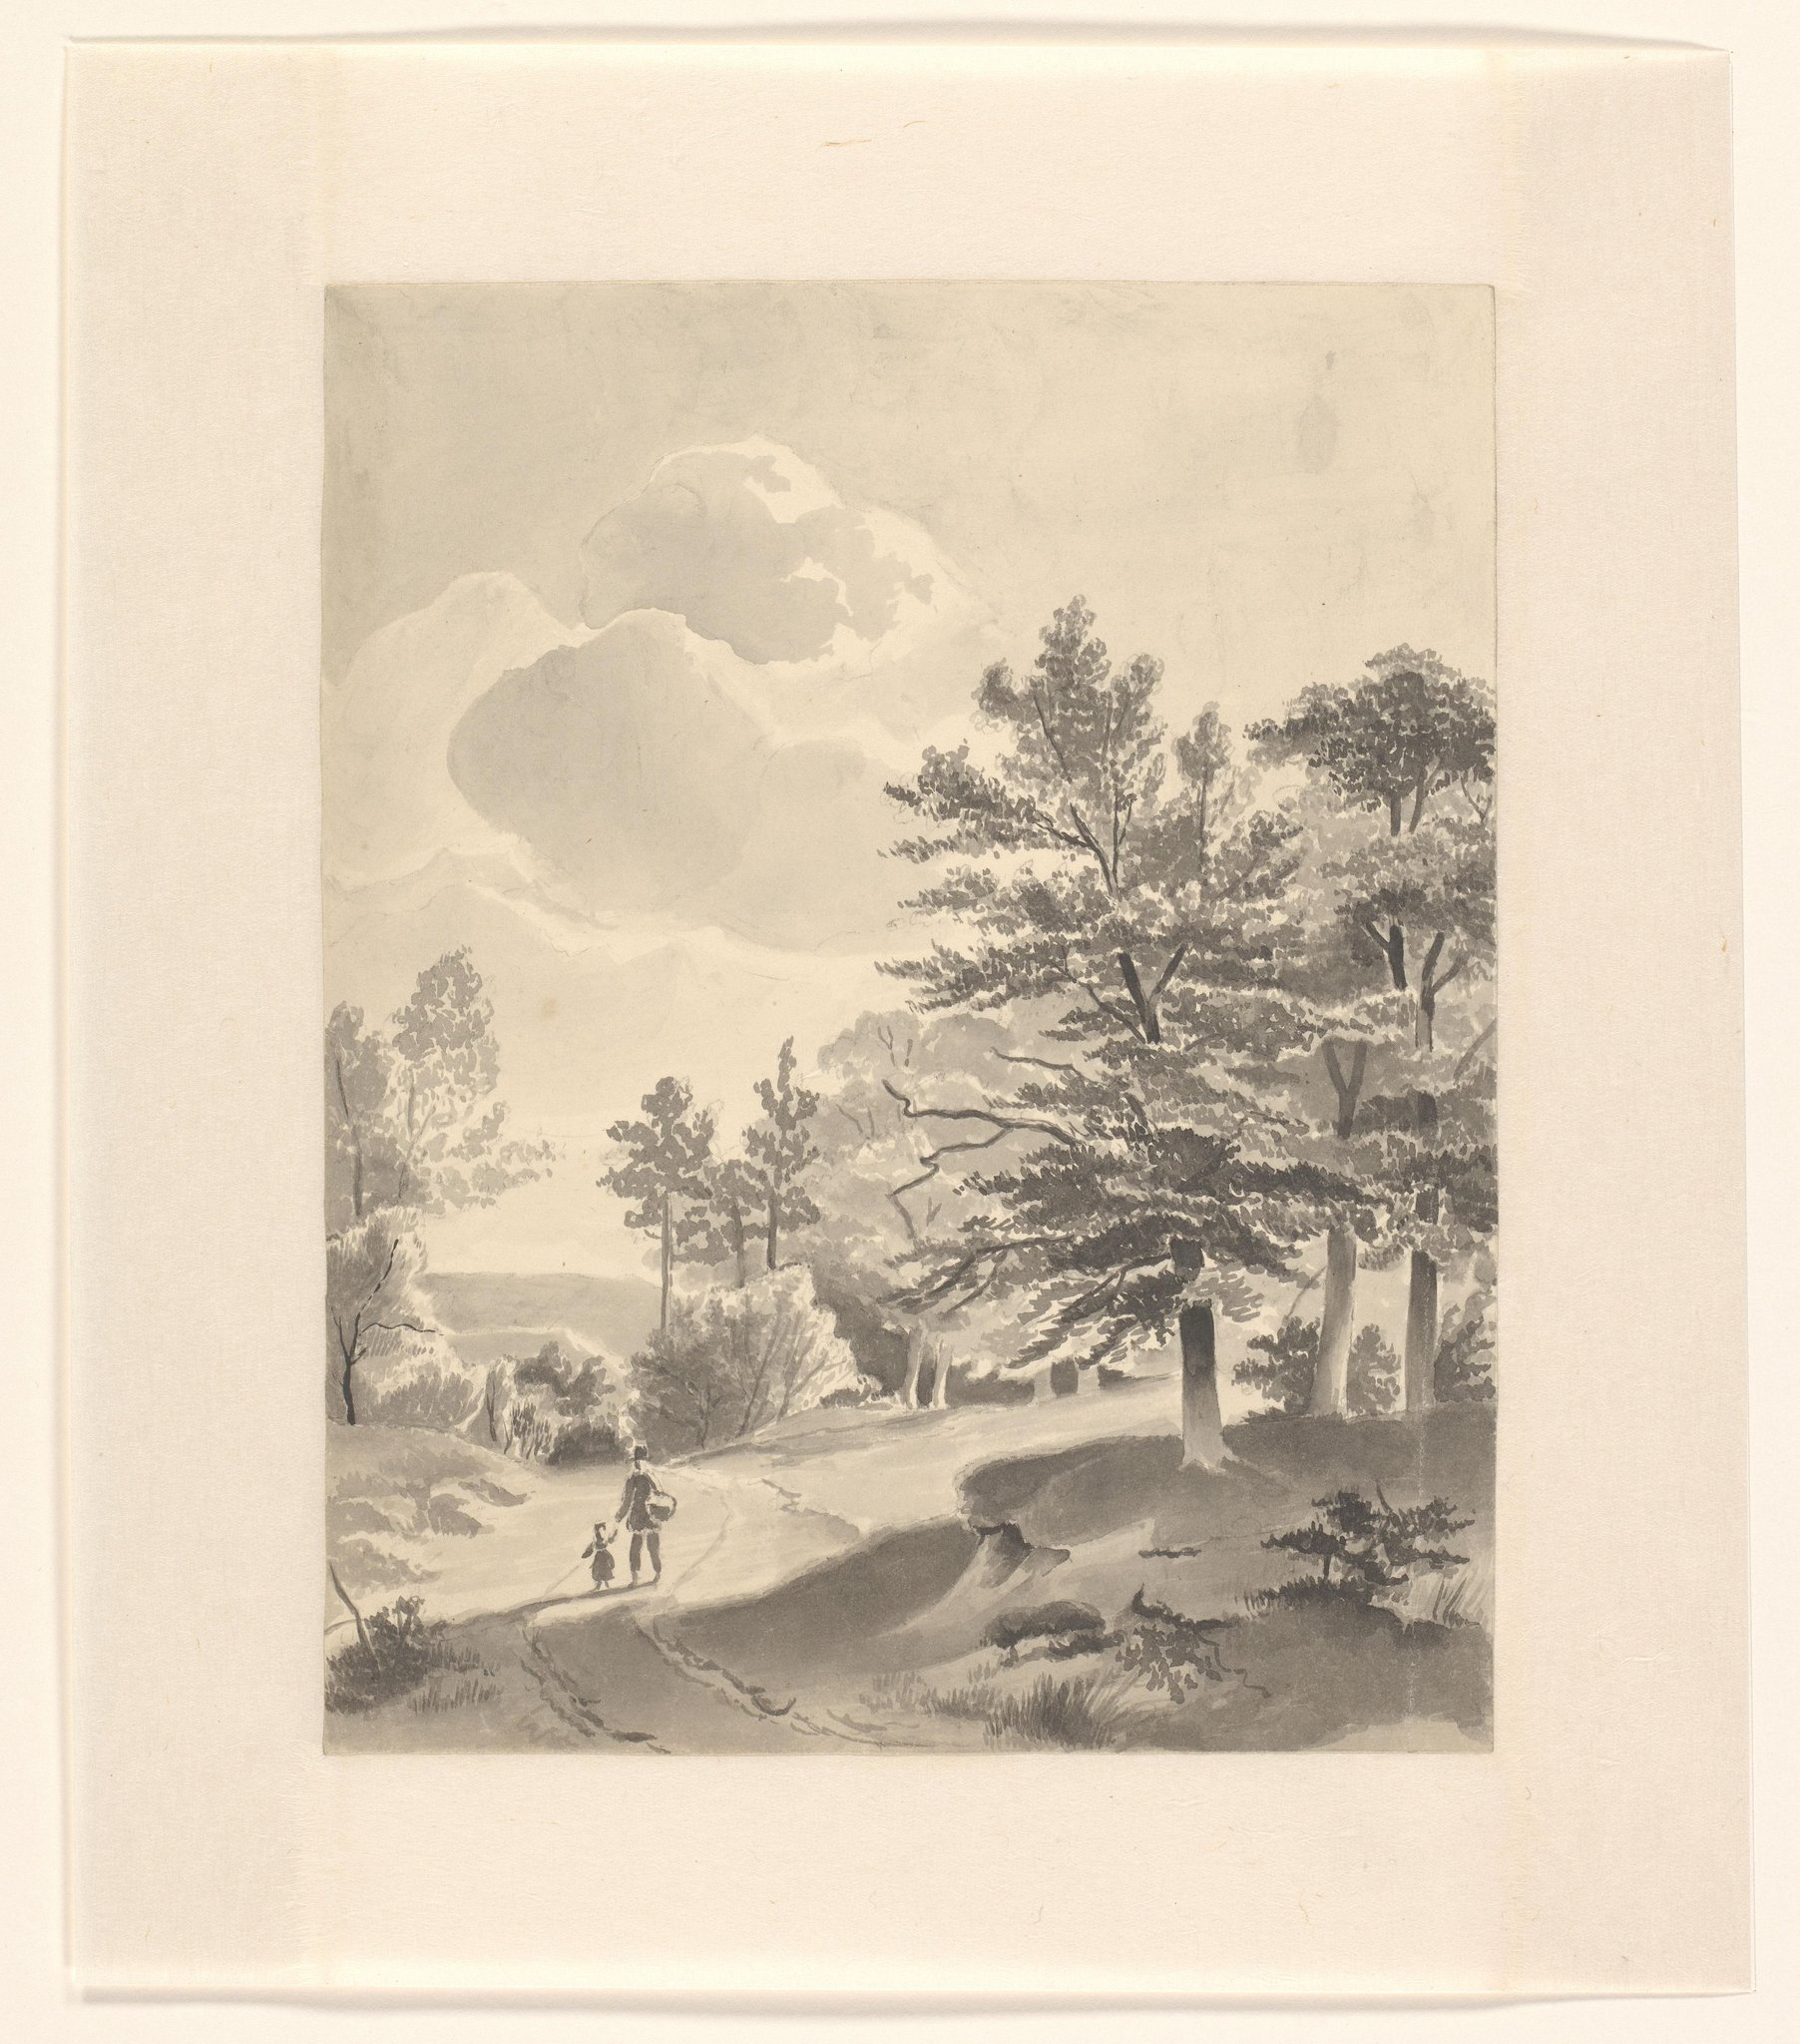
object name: drawing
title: Landschap met wandelaars op een pad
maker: johannes van reijn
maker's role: draughtsman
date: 1845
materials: ink, paper, pencil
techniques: brush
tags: road, path, landscapes (+ landscape with figures, staffage)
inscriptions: number: ‘No 1’, signature and date: ‘1845 by Mr VR’